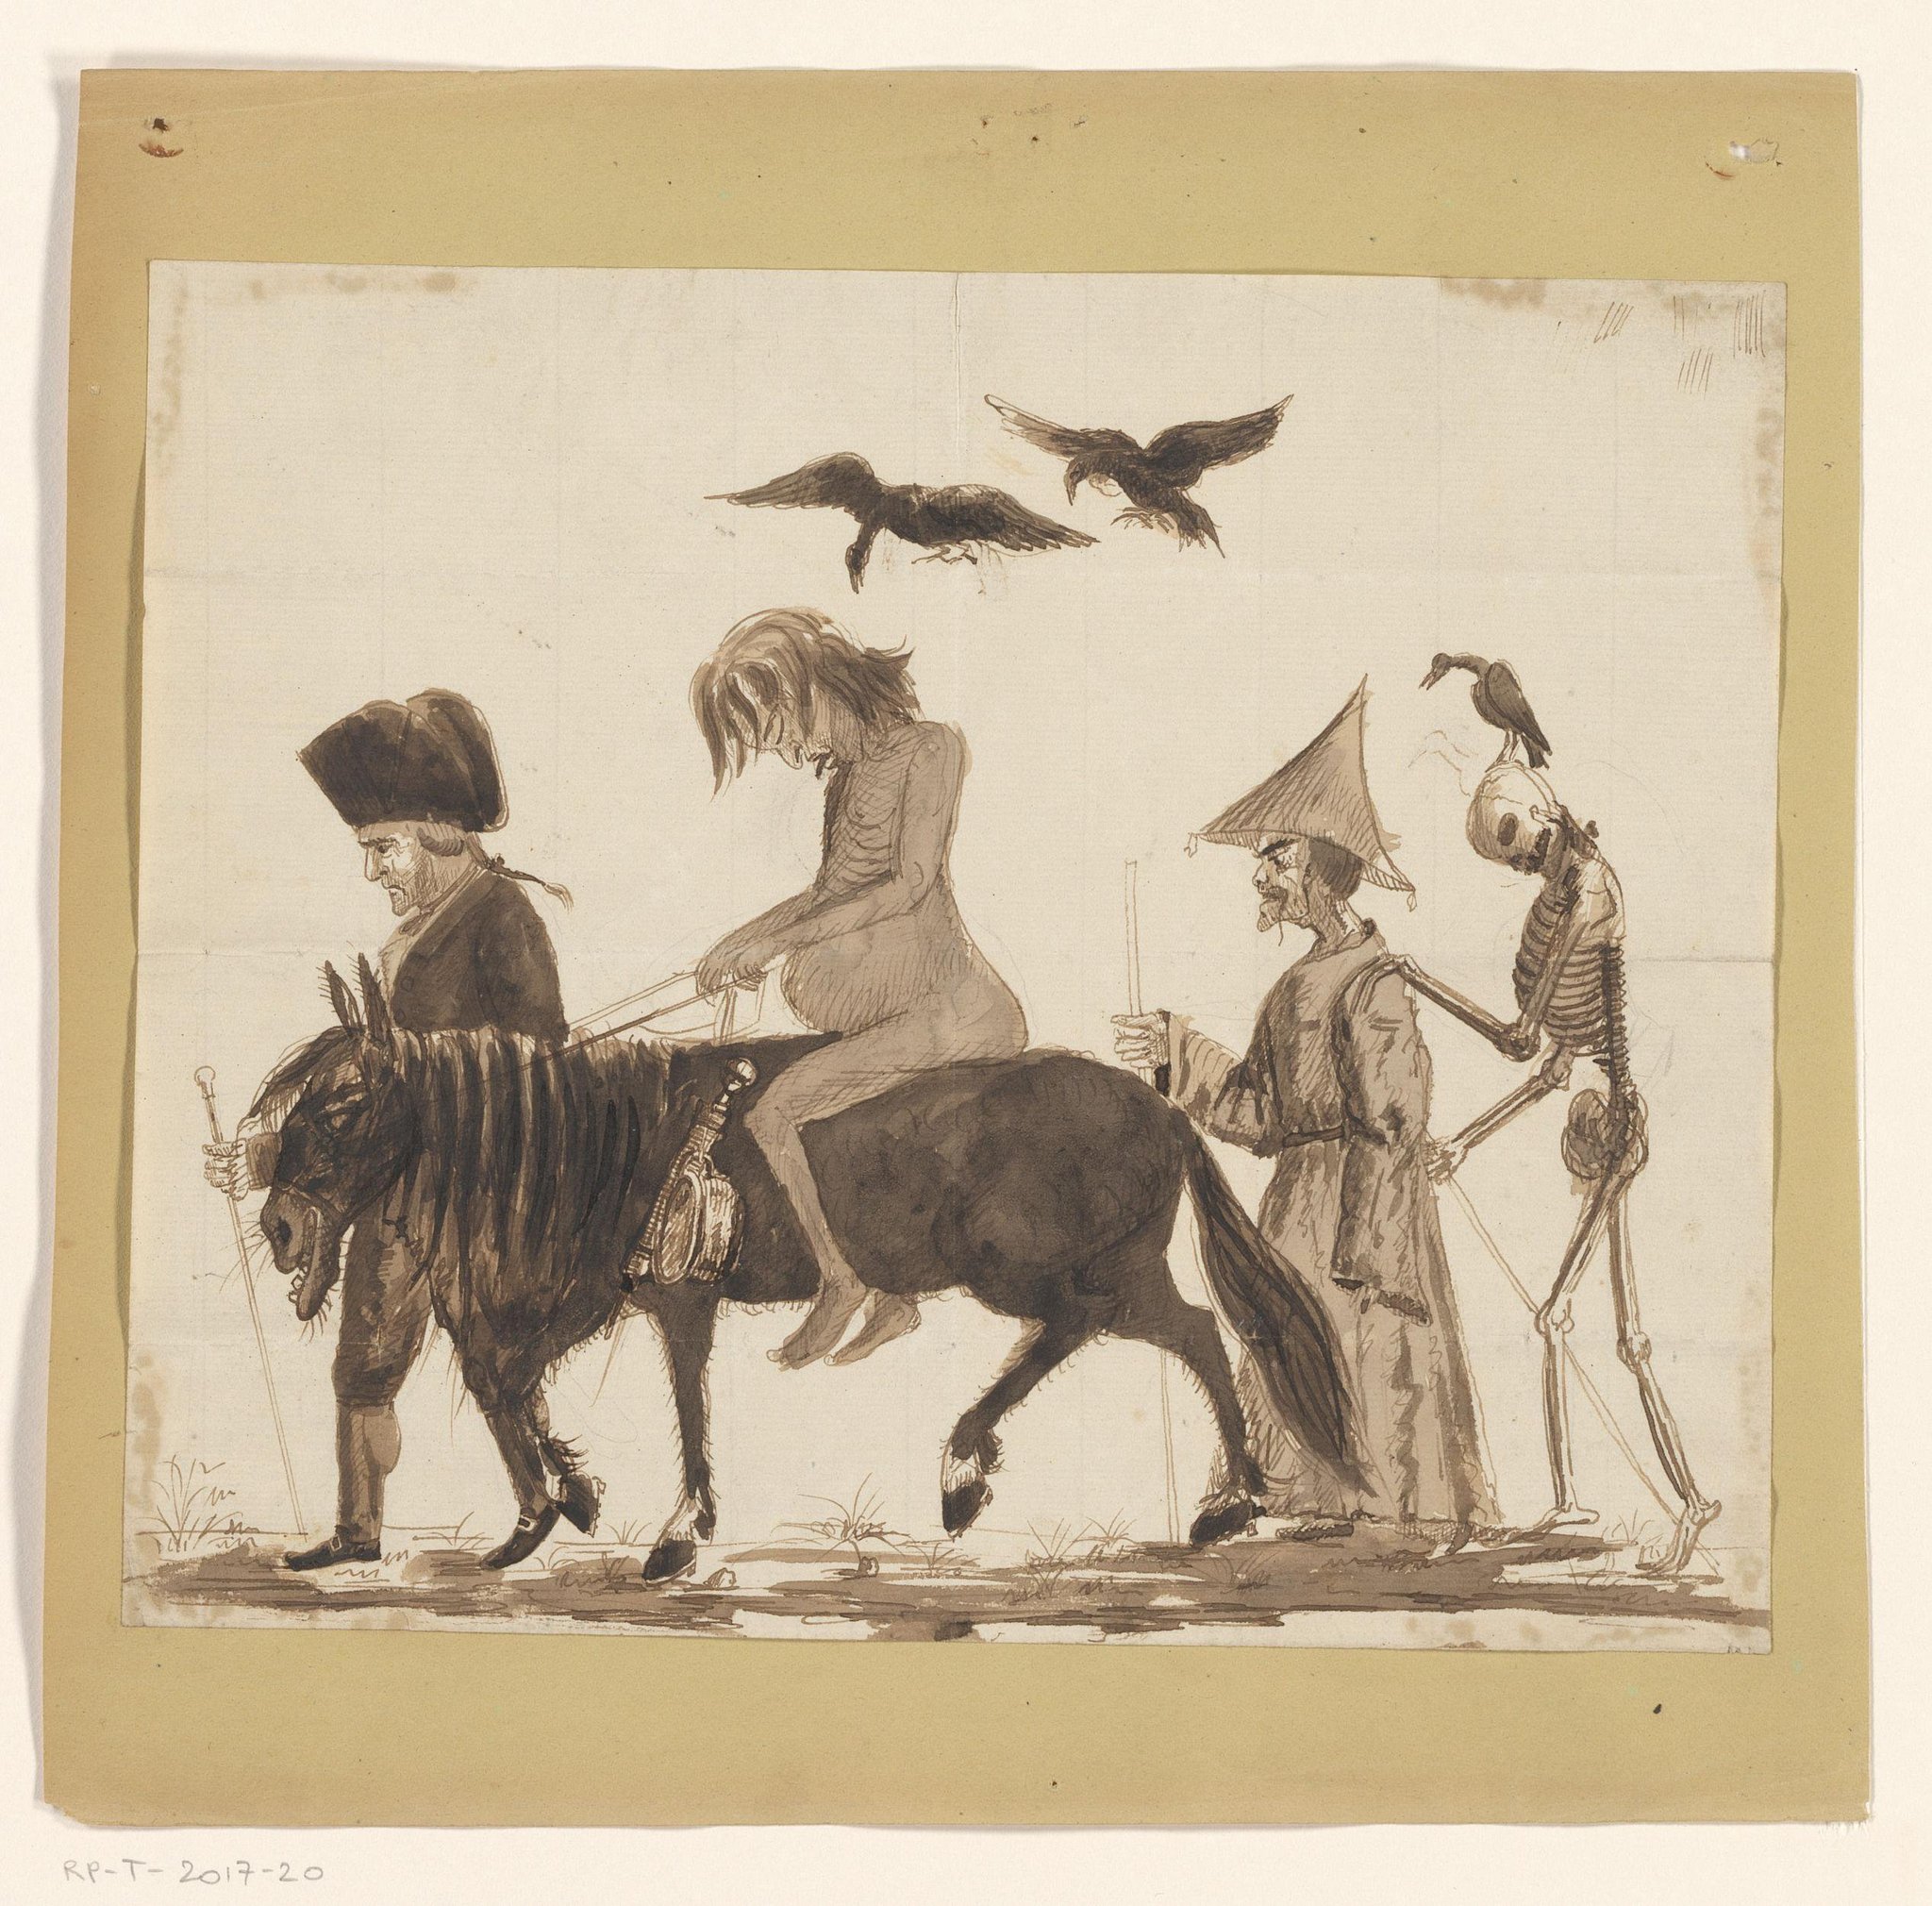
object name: cartoon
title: Franse terugtocht uit Rusland, 1812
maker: Anonymous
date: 1812-1815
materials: ink, paper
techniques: brush, pen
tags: chinese, death as skeleton, predatory birds: vulture, retreat of the defeated, political caricatures and satires, russia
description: Spotprent, mogelijk op de Franse terugtocht uit Rusland, 1812. Een naakte ruiter voorover gebogen rijdend op een paard. Het paard geleid door een Franse soldaat, achter lopen een Chinees (?) en de Dood. In de lucht twee gieren.